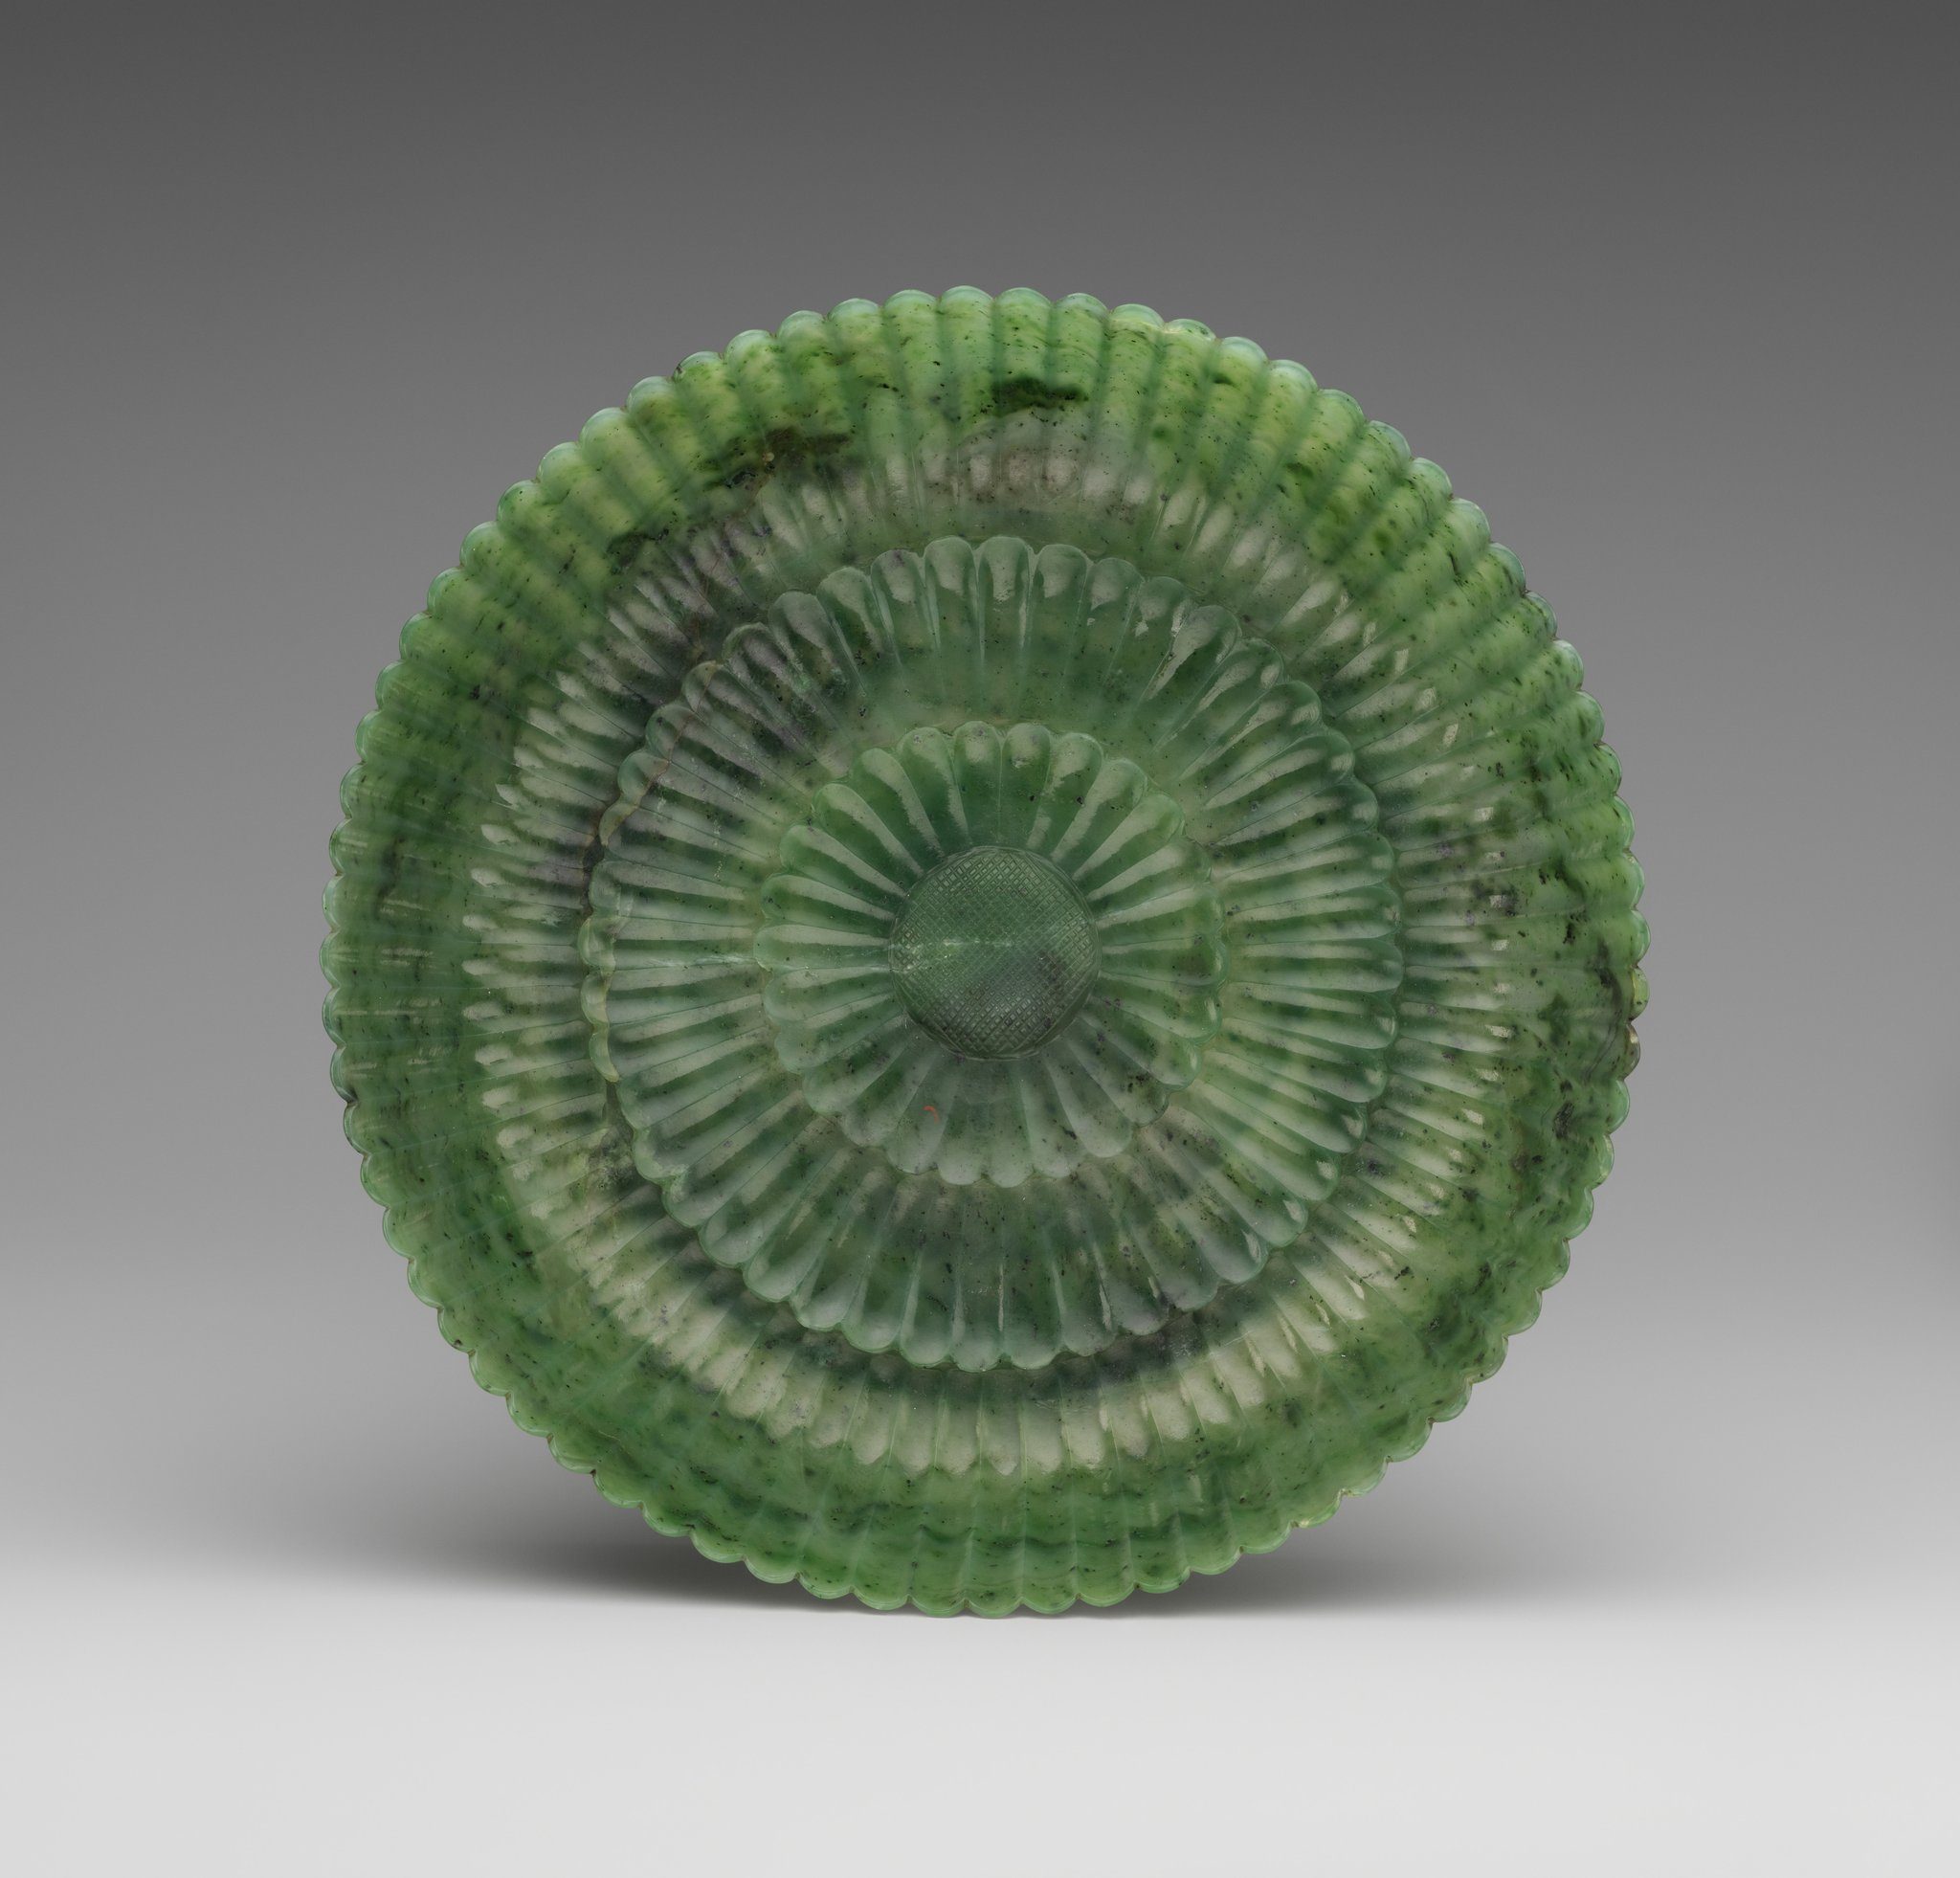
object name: dish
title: Dish in the shape of a chrysanthemum flower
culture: chinese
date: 1701-1900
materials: jade